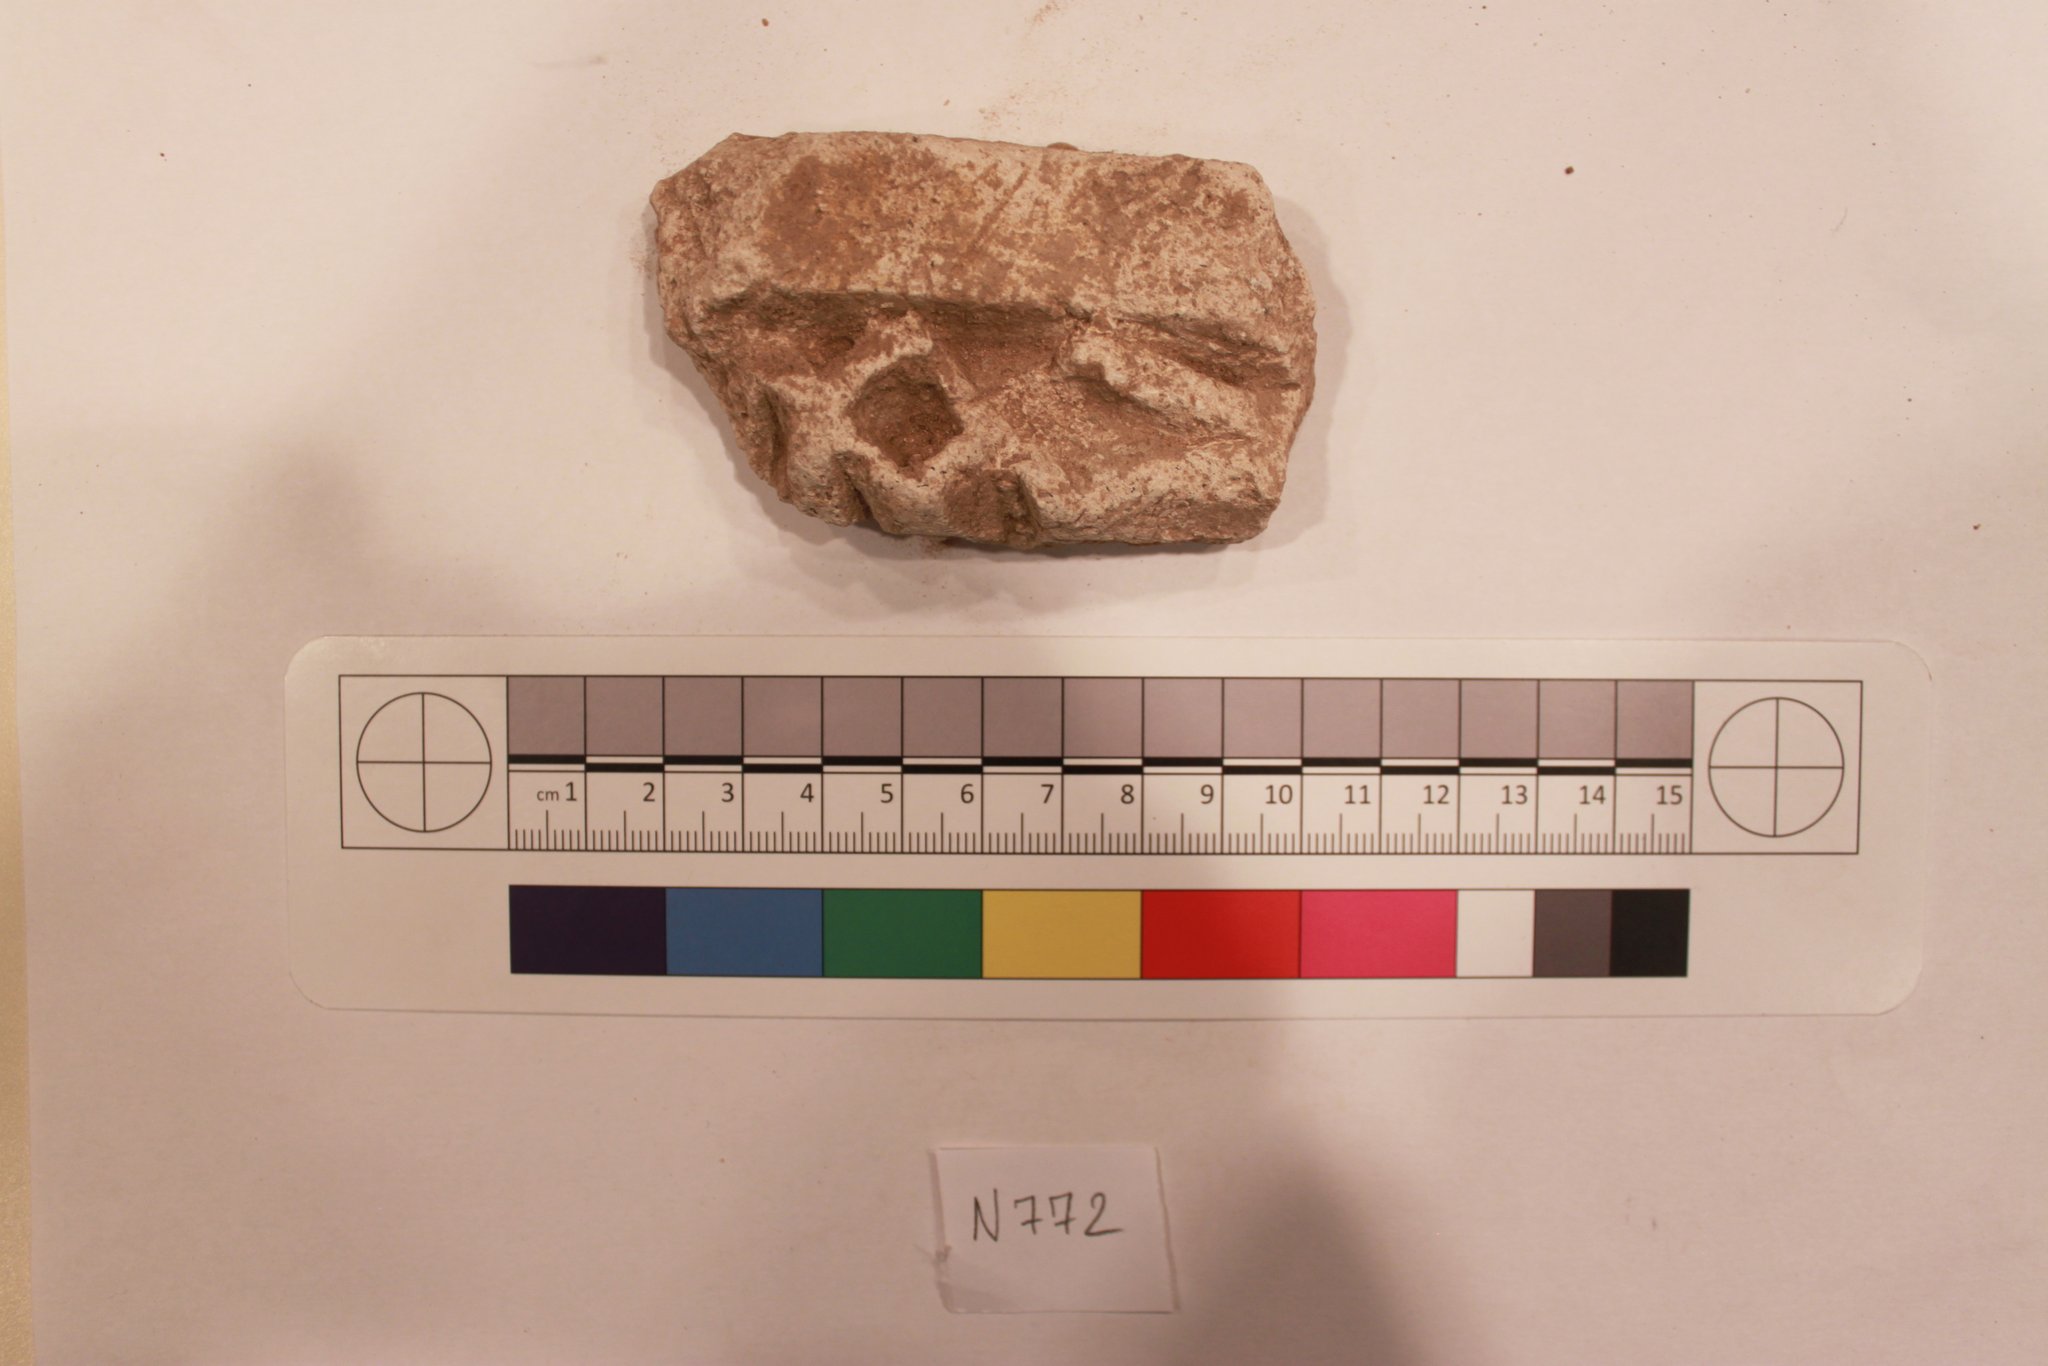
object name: fragment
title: Stucco Fragment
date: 701-1200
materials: plaster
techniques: carving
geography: iran